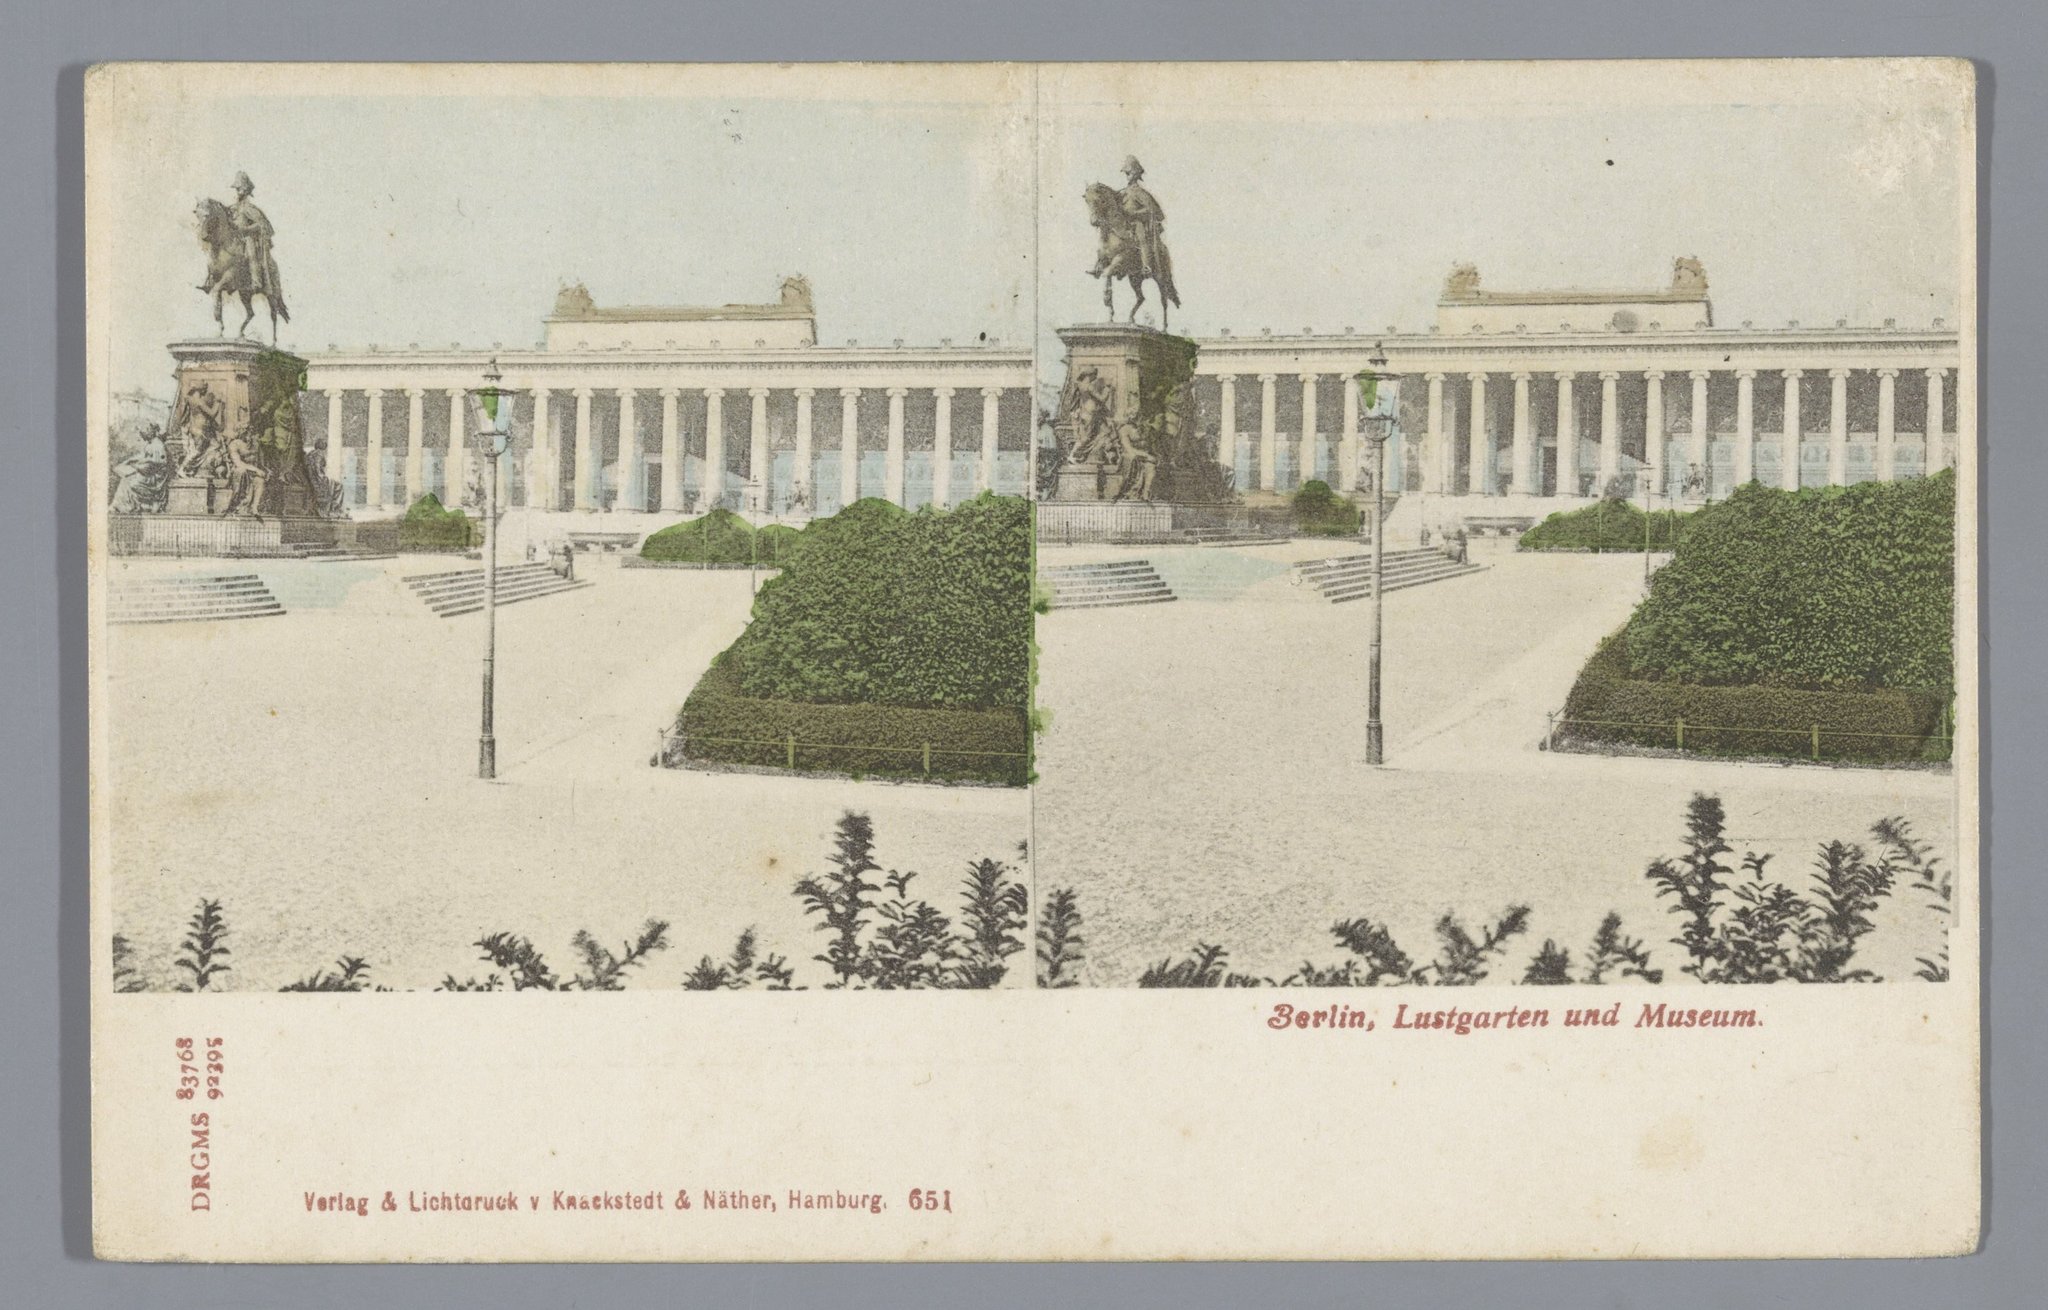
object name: ansichtkaart, prentbriefkaart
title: Lustgarten en het Altes Museum in Berlijn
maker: Anonymous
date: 1889-1905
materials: cardboard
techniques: photograph, hand coloring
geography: hamburg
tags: square, place, circus, etc., monument, statue, public gardens, park, berlin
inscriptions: inscription: ‘DRGMS 83768/ 92395’, inscription: ‘Post-Karte’, number: ‘651’